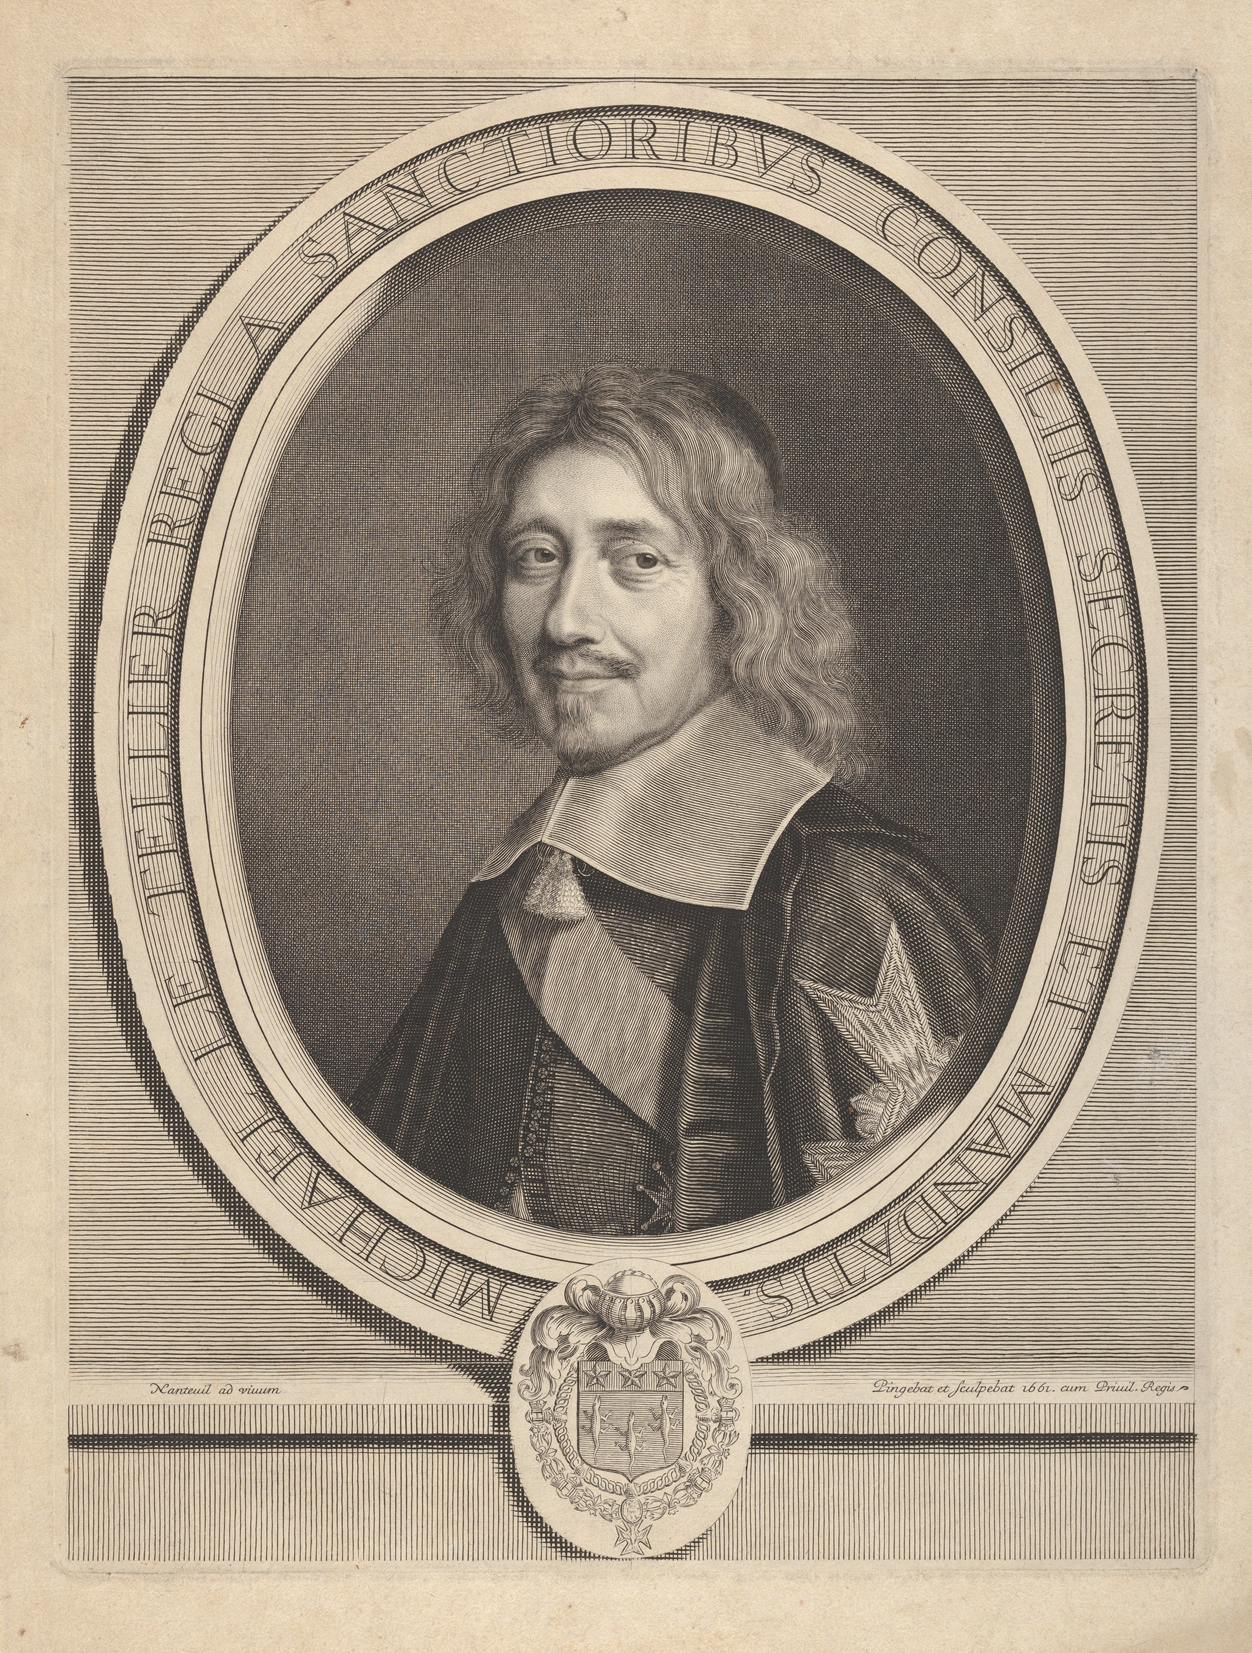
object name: print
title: Chancelier Michel IV Le Tellier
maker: robert nanteuil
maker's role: artist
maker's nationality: french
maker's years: 1623-1678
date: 1661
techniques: engraving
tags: men,portraits,coat of arms